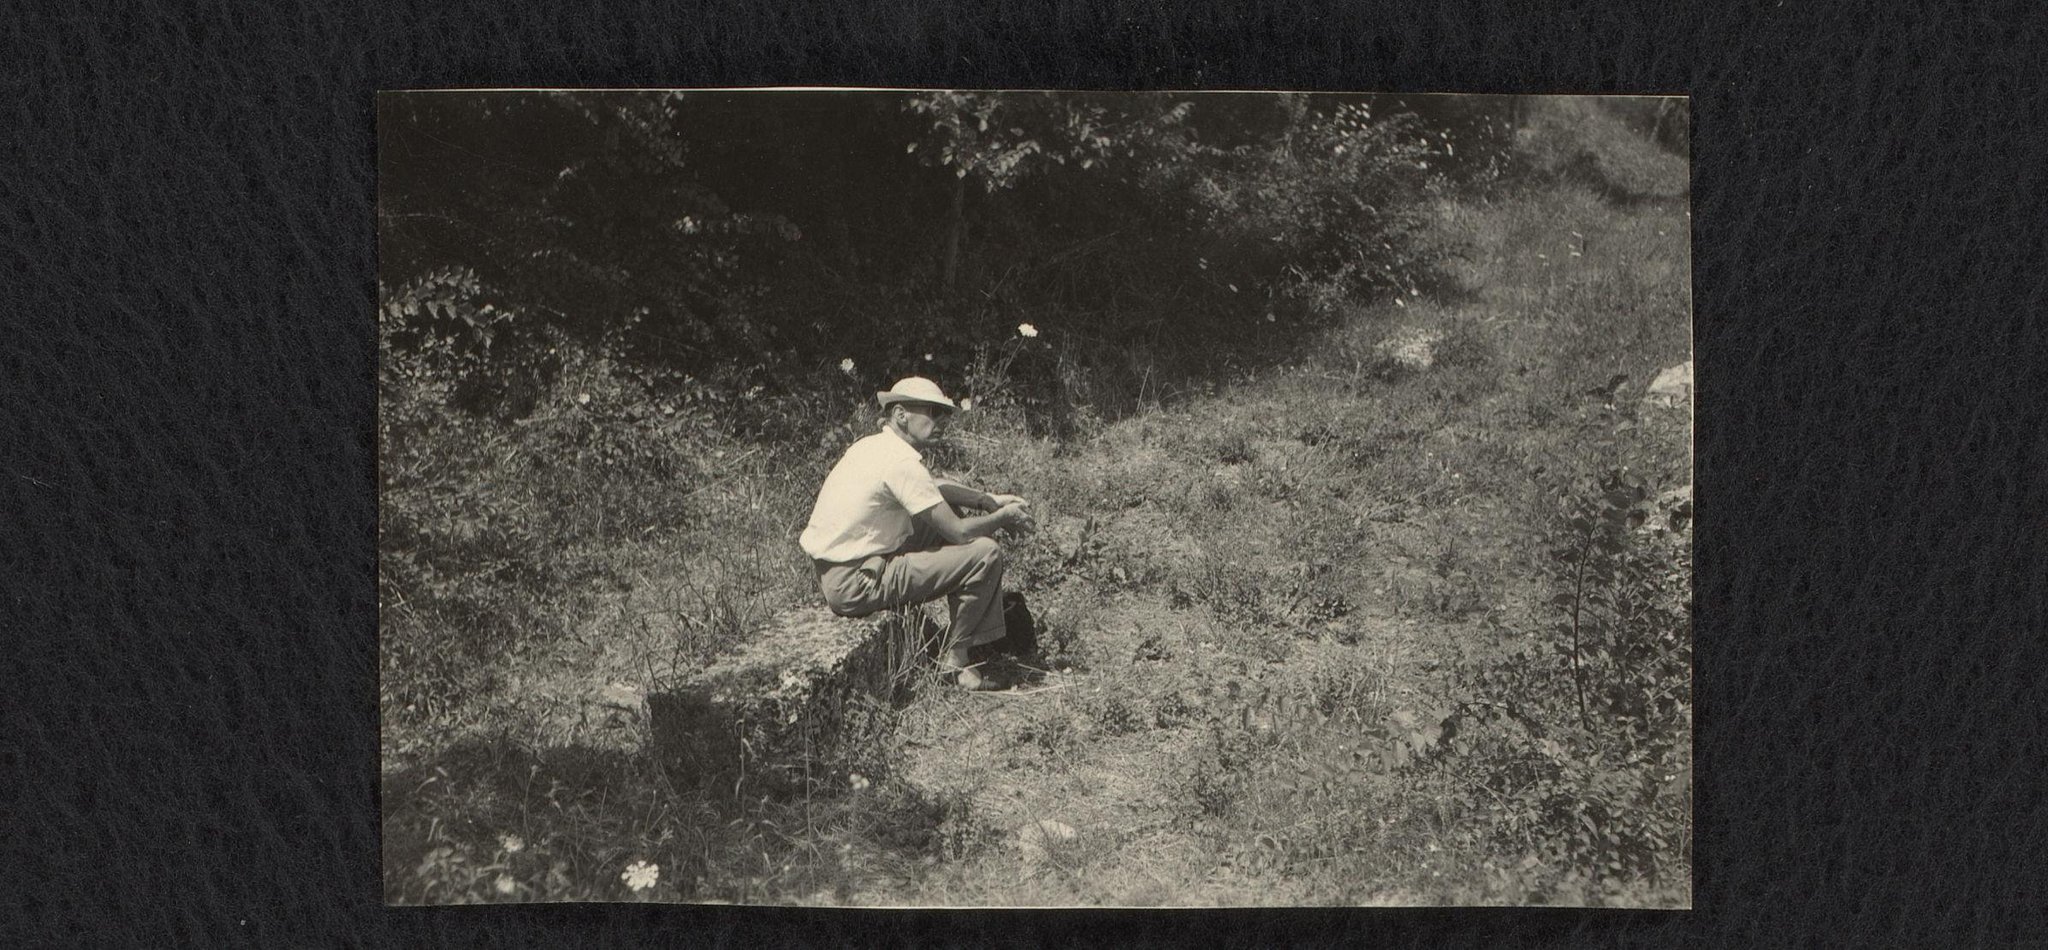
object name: photograph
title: Tempel bij Paestum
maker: Anonymous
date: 1954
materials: paper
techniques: gelatin silver print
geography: paestum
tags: column, pillar ~ architecture, ruin of a building ~ architecture, temple, shrine ~ greek religion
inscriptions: number: ‘31’